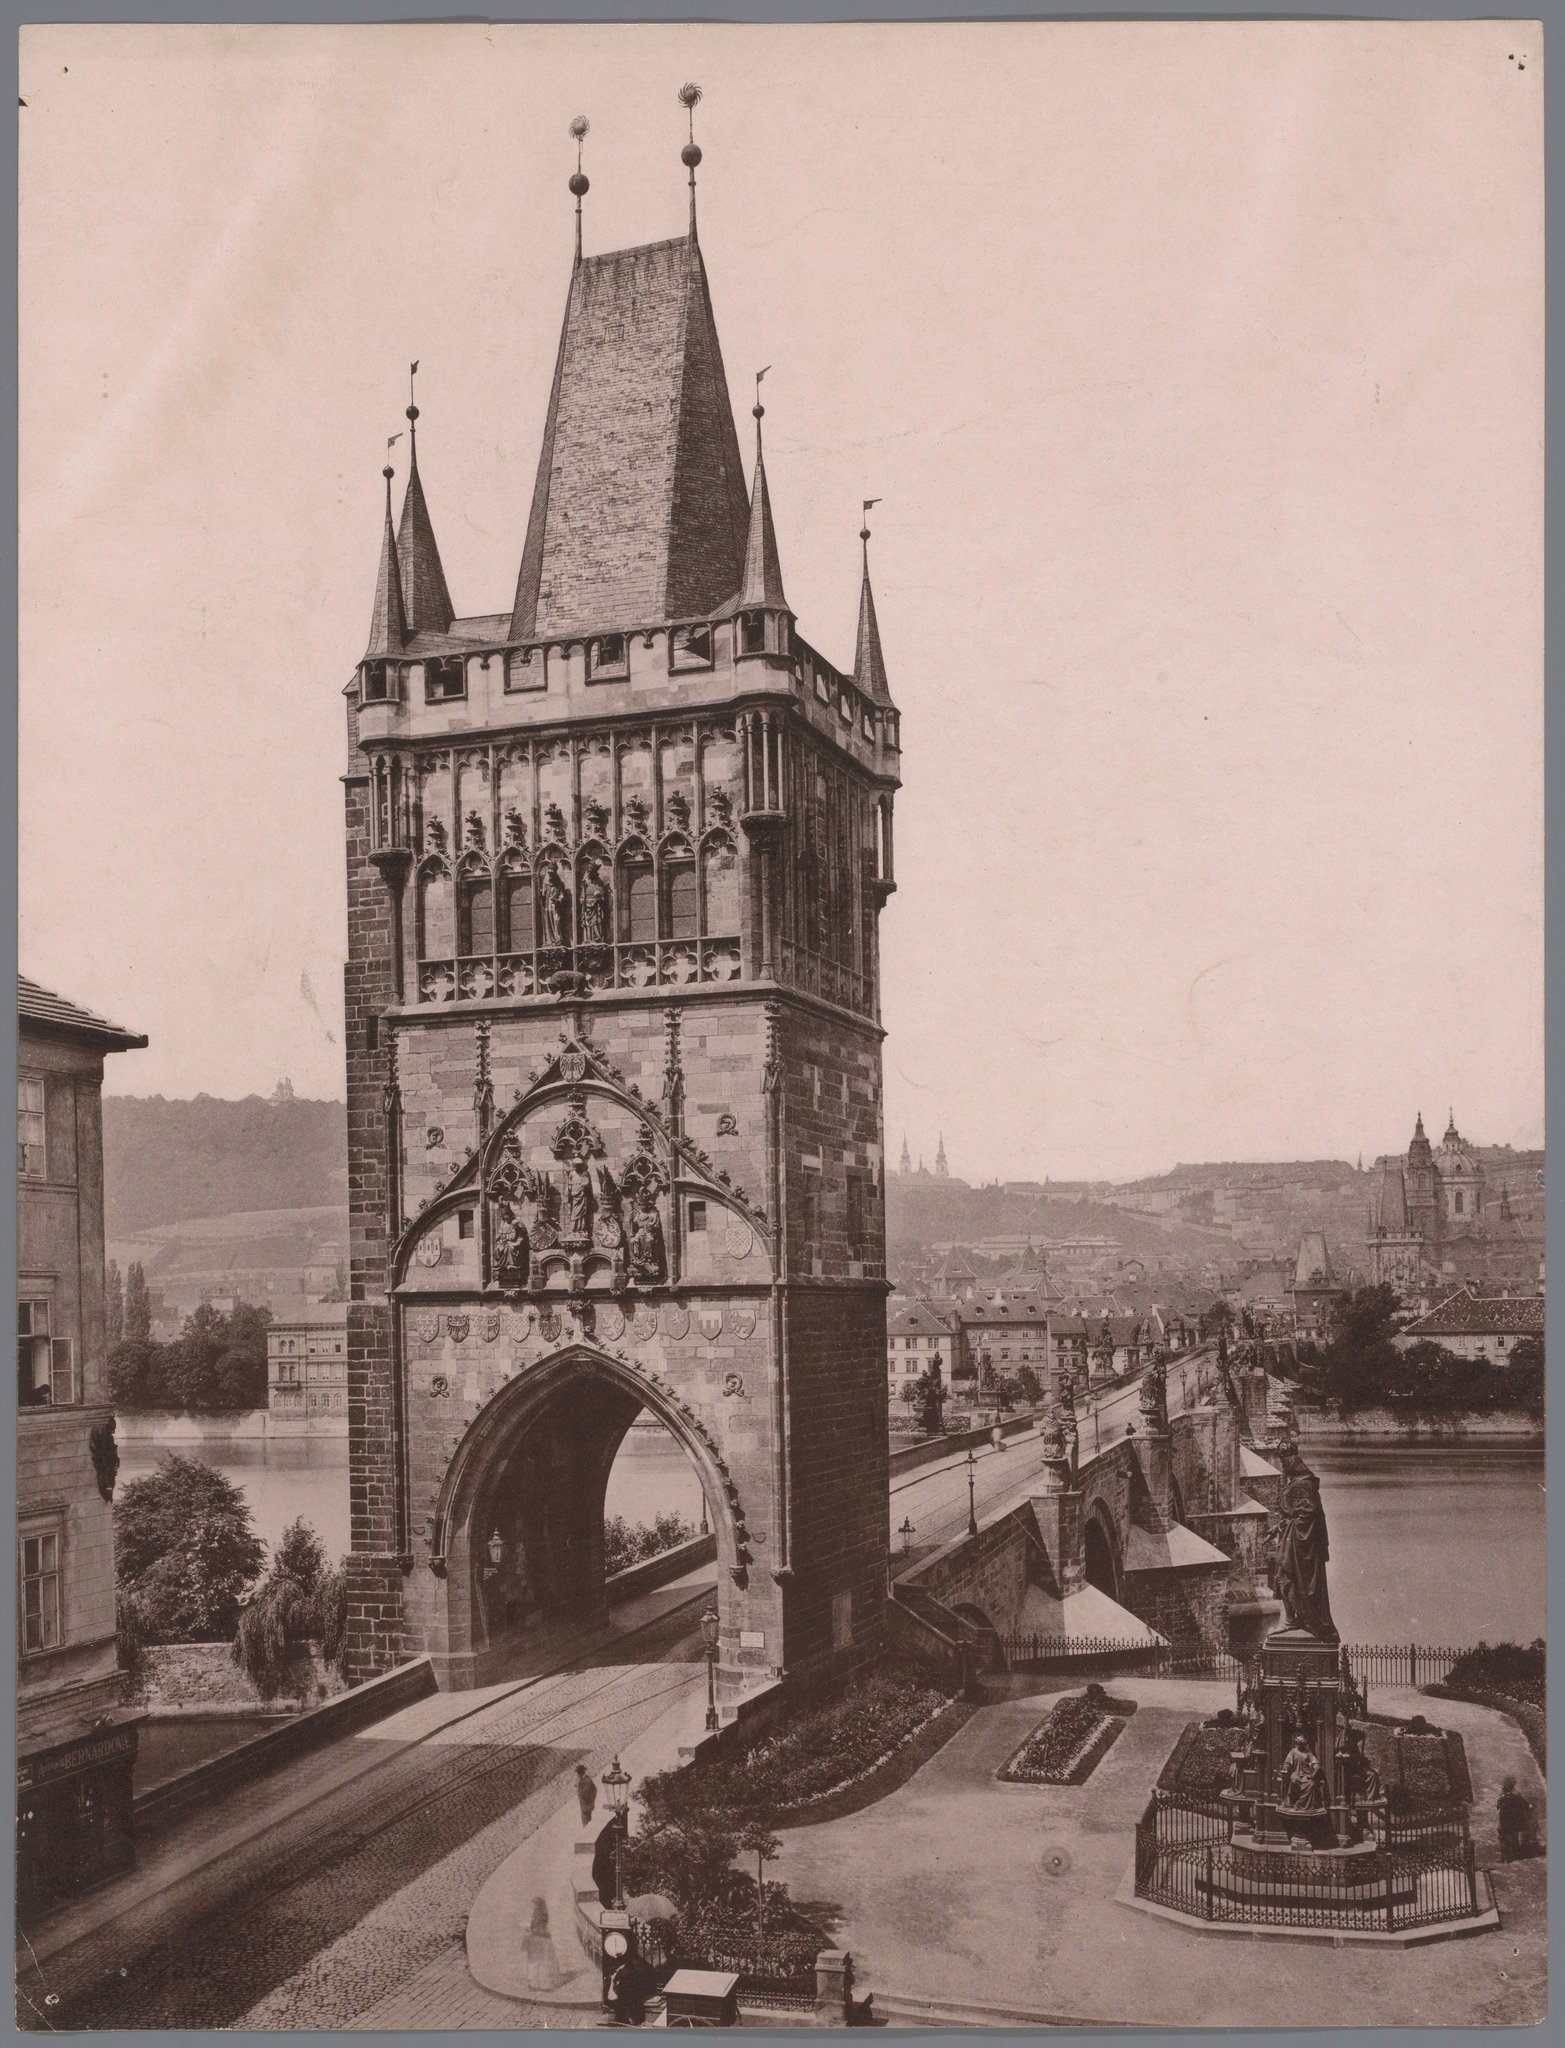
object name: photomechanical print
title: Praag, Bruckenturm (Altstadt)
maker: Anonymous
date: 1870-1930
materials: paper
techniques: photograph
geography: prague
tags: bridge in city across river, canal, etc.